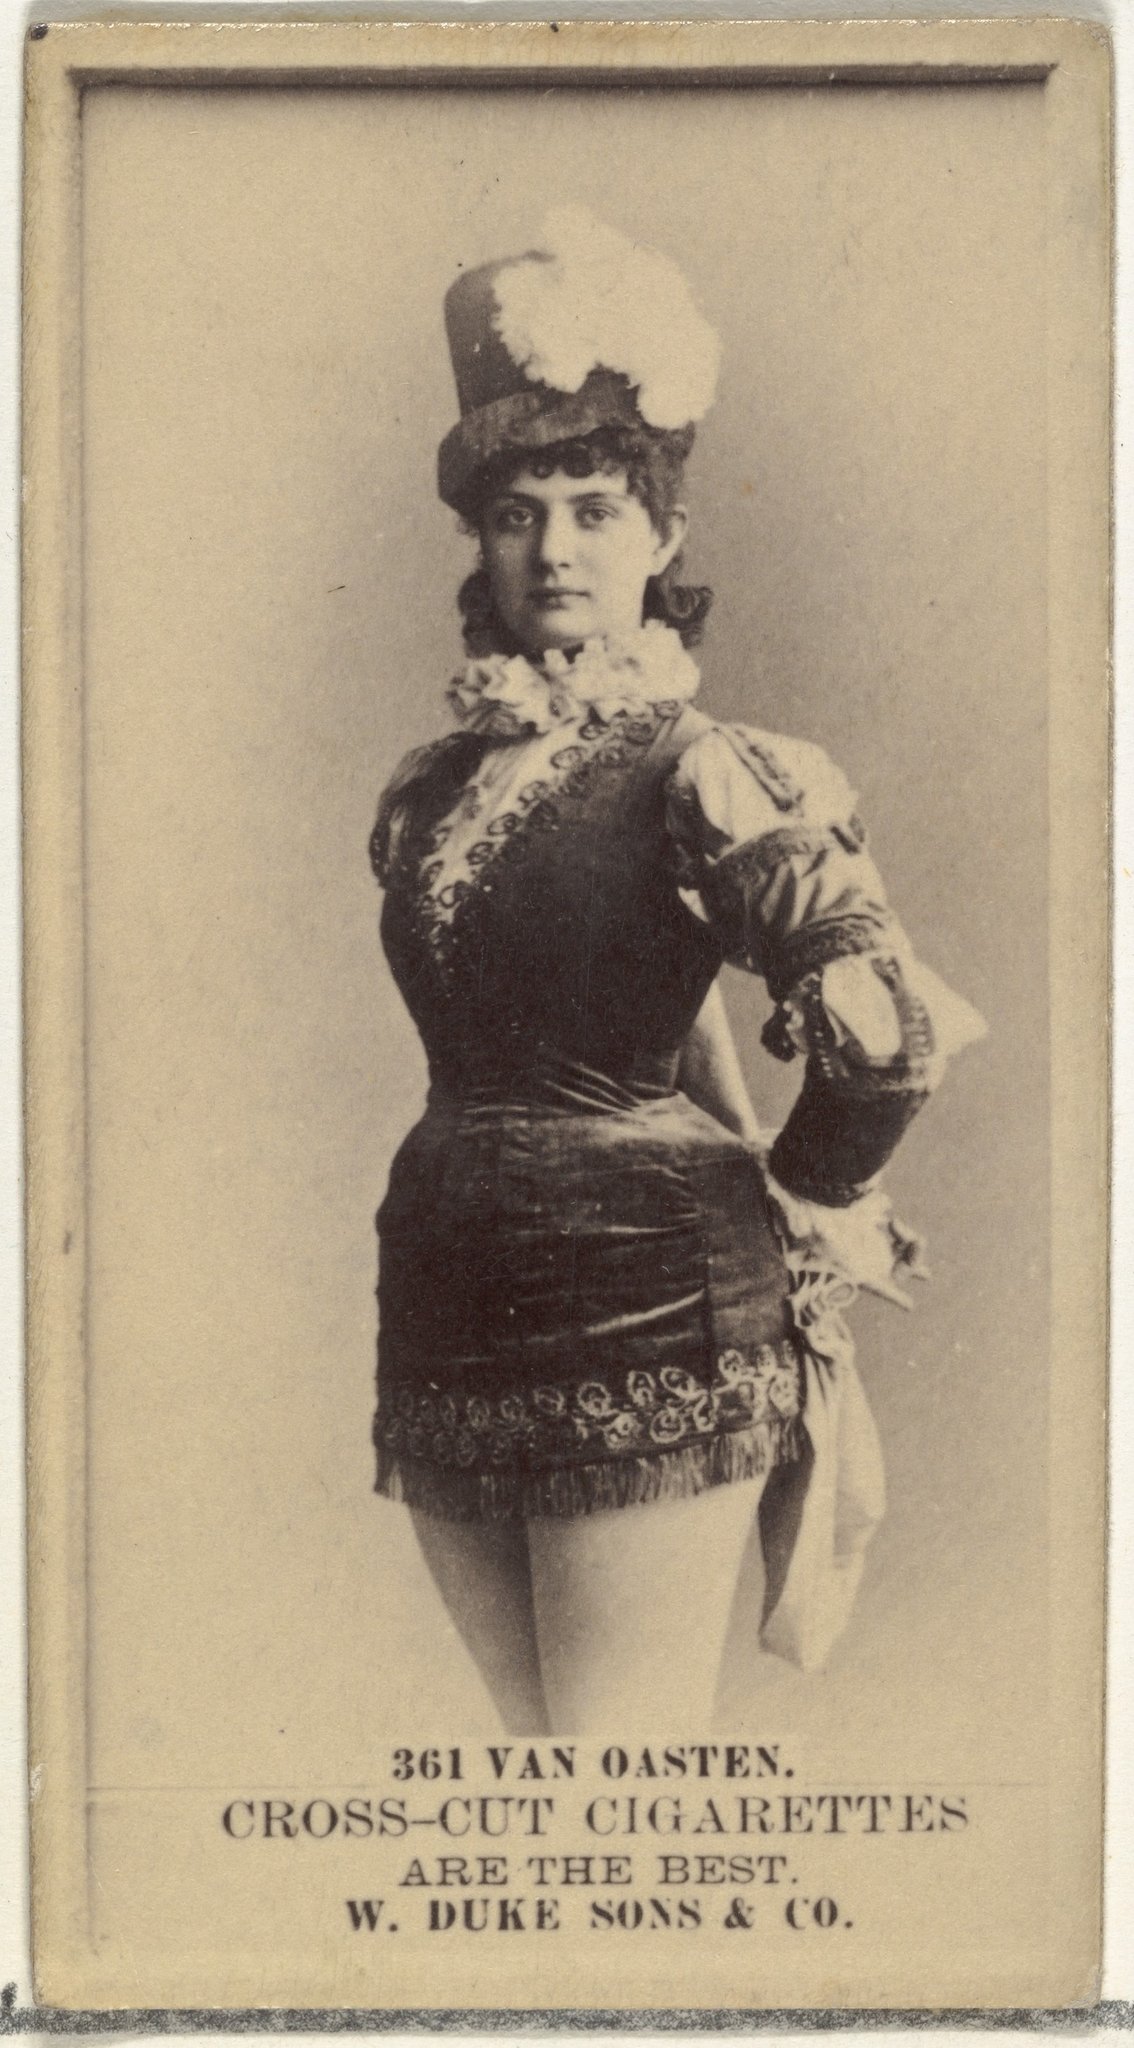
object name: photograph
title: Card Number 361, Von Oasten, from the Actors and Actresses series (N145-3) issued by Duke Sons & Co. to promote Cross Cut Cigarettes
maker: w. duke, sons & co.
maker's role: publisher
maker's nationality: american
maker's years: 1870-1920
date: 1880-1889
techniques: albumen silver print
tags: portraits,women,actresses